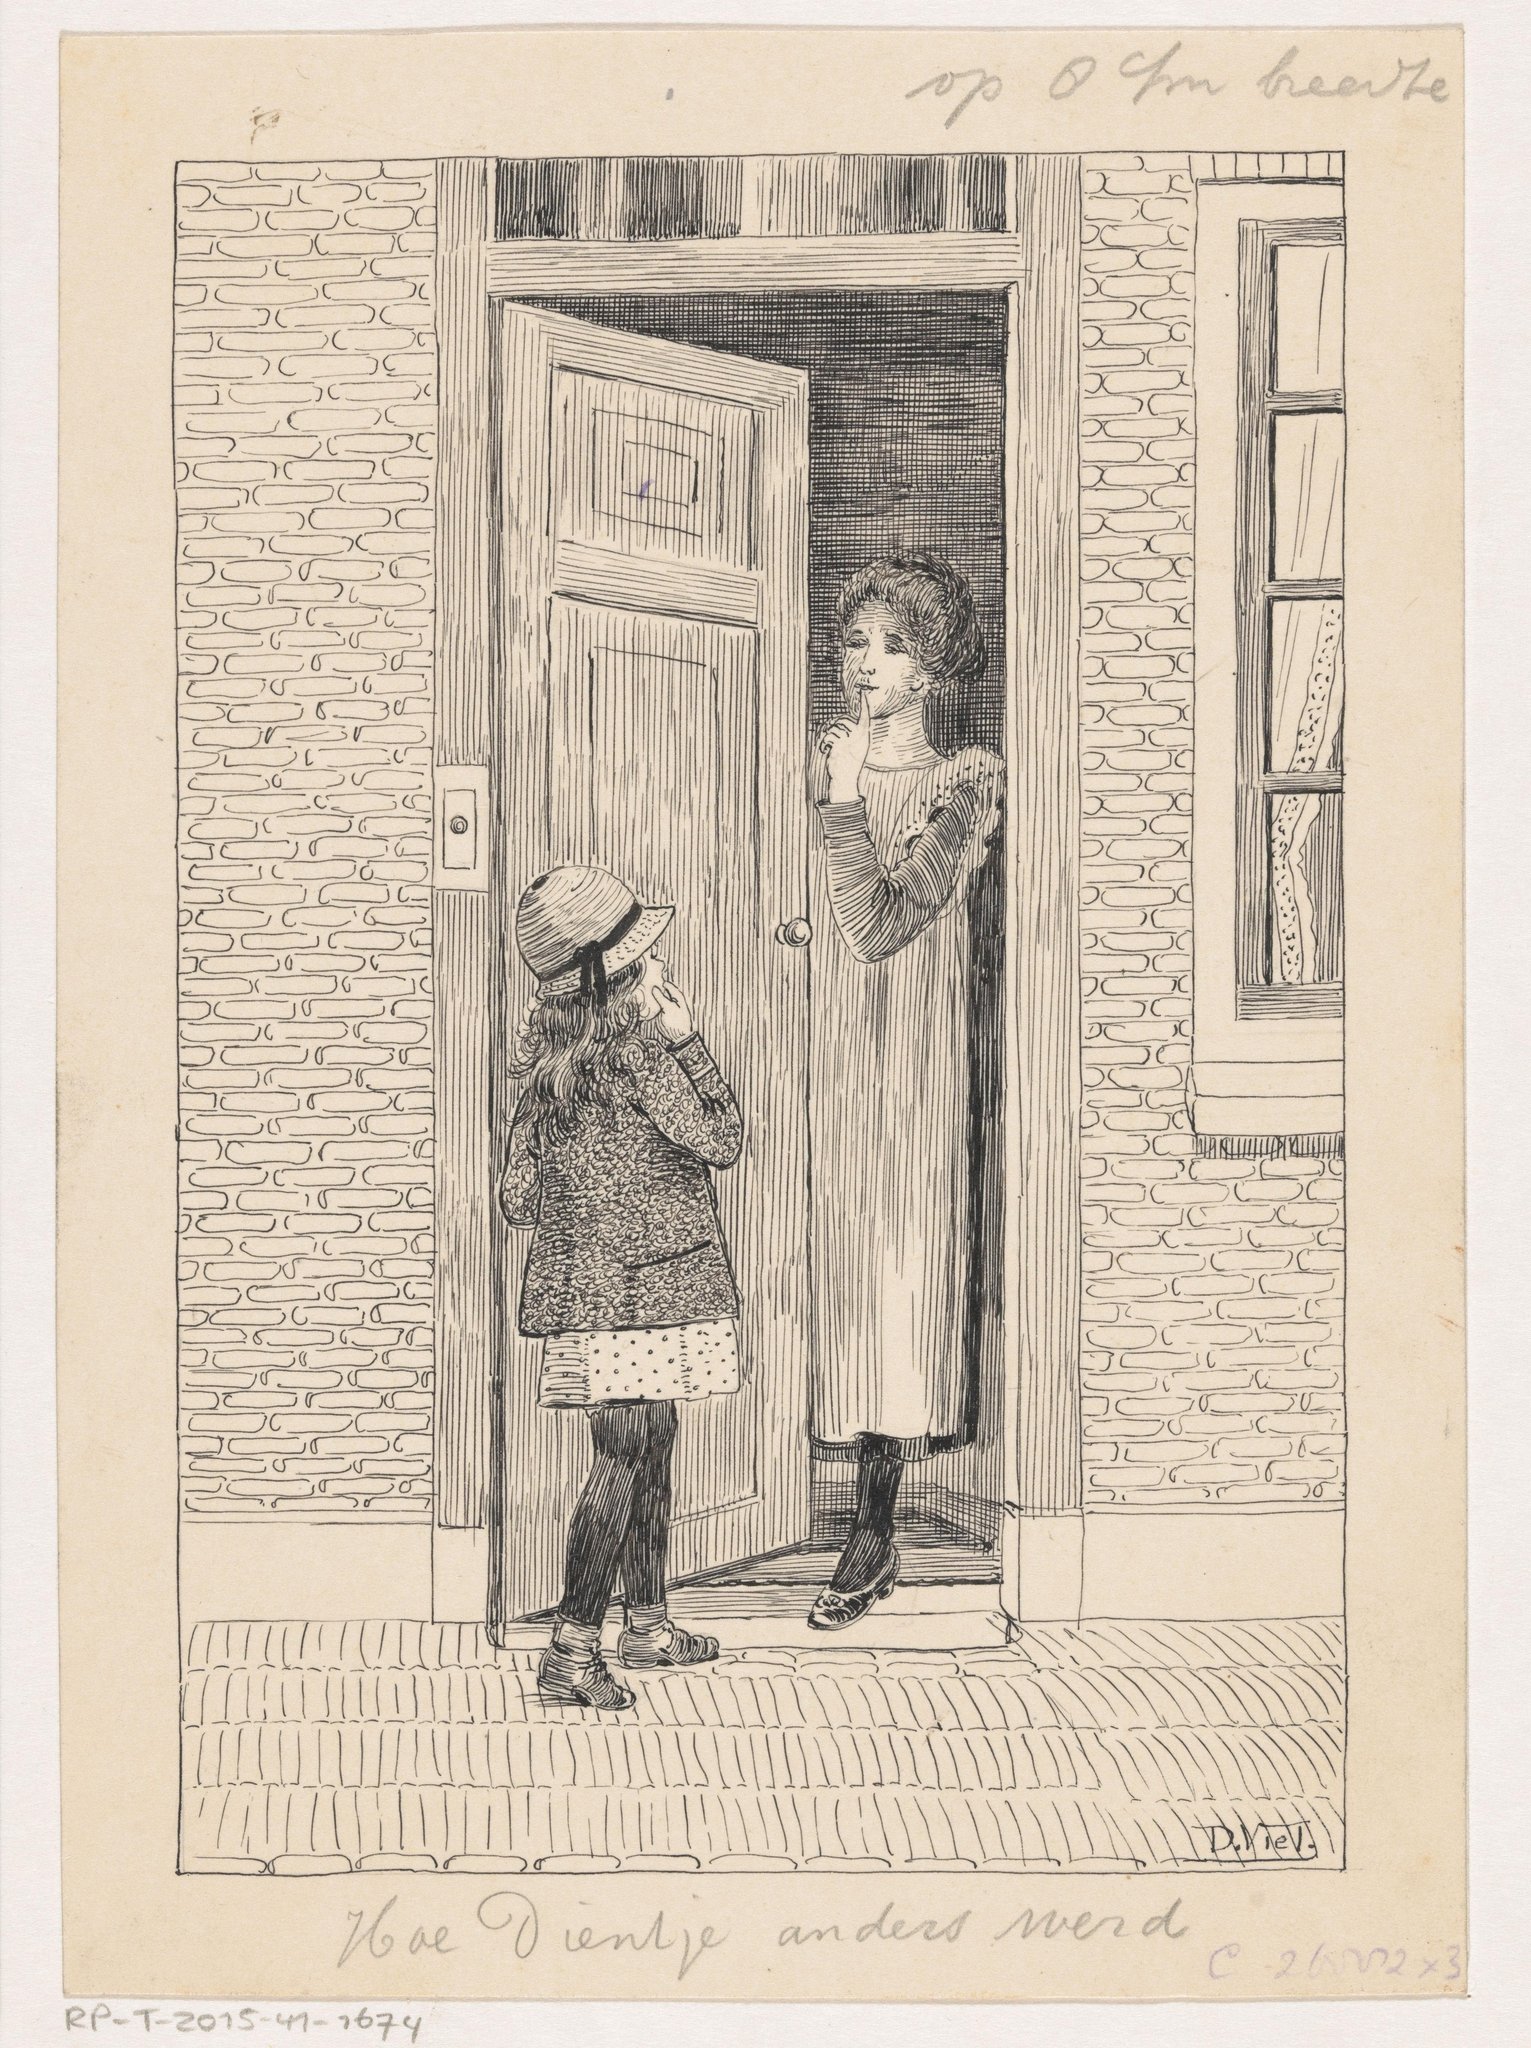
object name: drawing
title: Vrouw maakt stiltegebaar in een deuropening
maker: d. viel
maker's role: draughtsman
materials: ink, paper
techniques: pen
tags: open door, putting a finger to the lips, 'silentium'; 'silentio' (ripa)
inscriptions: signature: ‘D. Viel.’, :, collector's mark: Lugt 2228, annotation: ‘Hoe Dientje anders werd’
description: Een vrouw staat in een deuropening en houdt haar wijsvinger voor haar lippen. Ze maant Dientje, die voor de deur op de stoep staat, tot stilte.